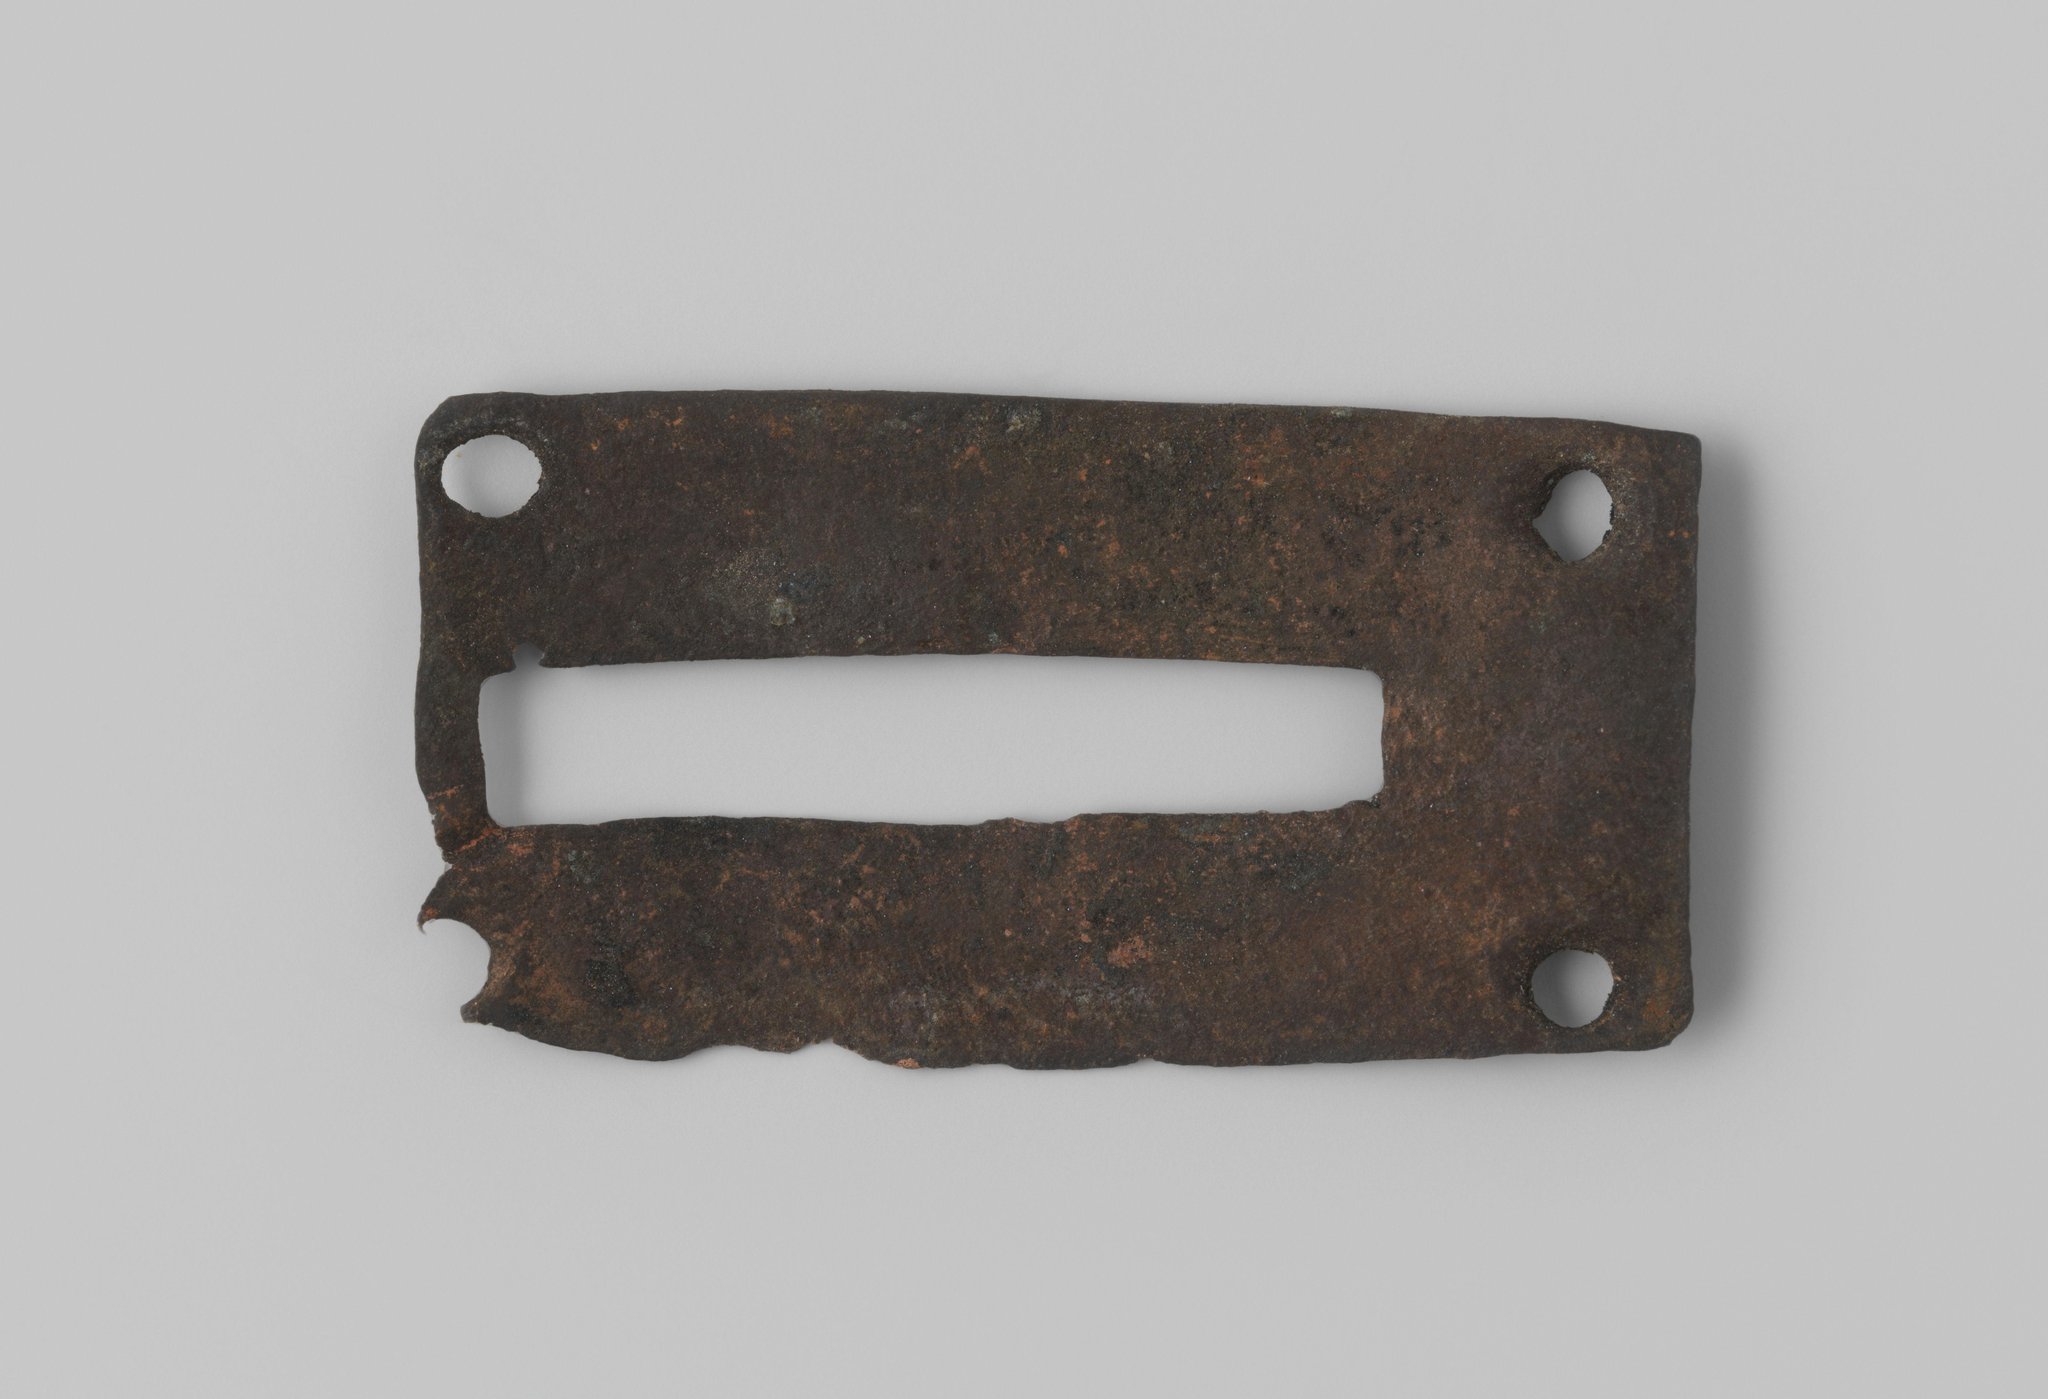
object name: musket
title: Trekkerplaat van een musket uit het wrak van de Oost-Indiëvaarder Hollandia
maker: Anonymous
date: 1700-1743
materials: copper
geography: netherlands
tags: verenigde oostindische compagnie, hollandia (schip), annet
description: Musket, trigger plate; rectangular plate with nail-holes in the 4 corners and an oblong central slot.